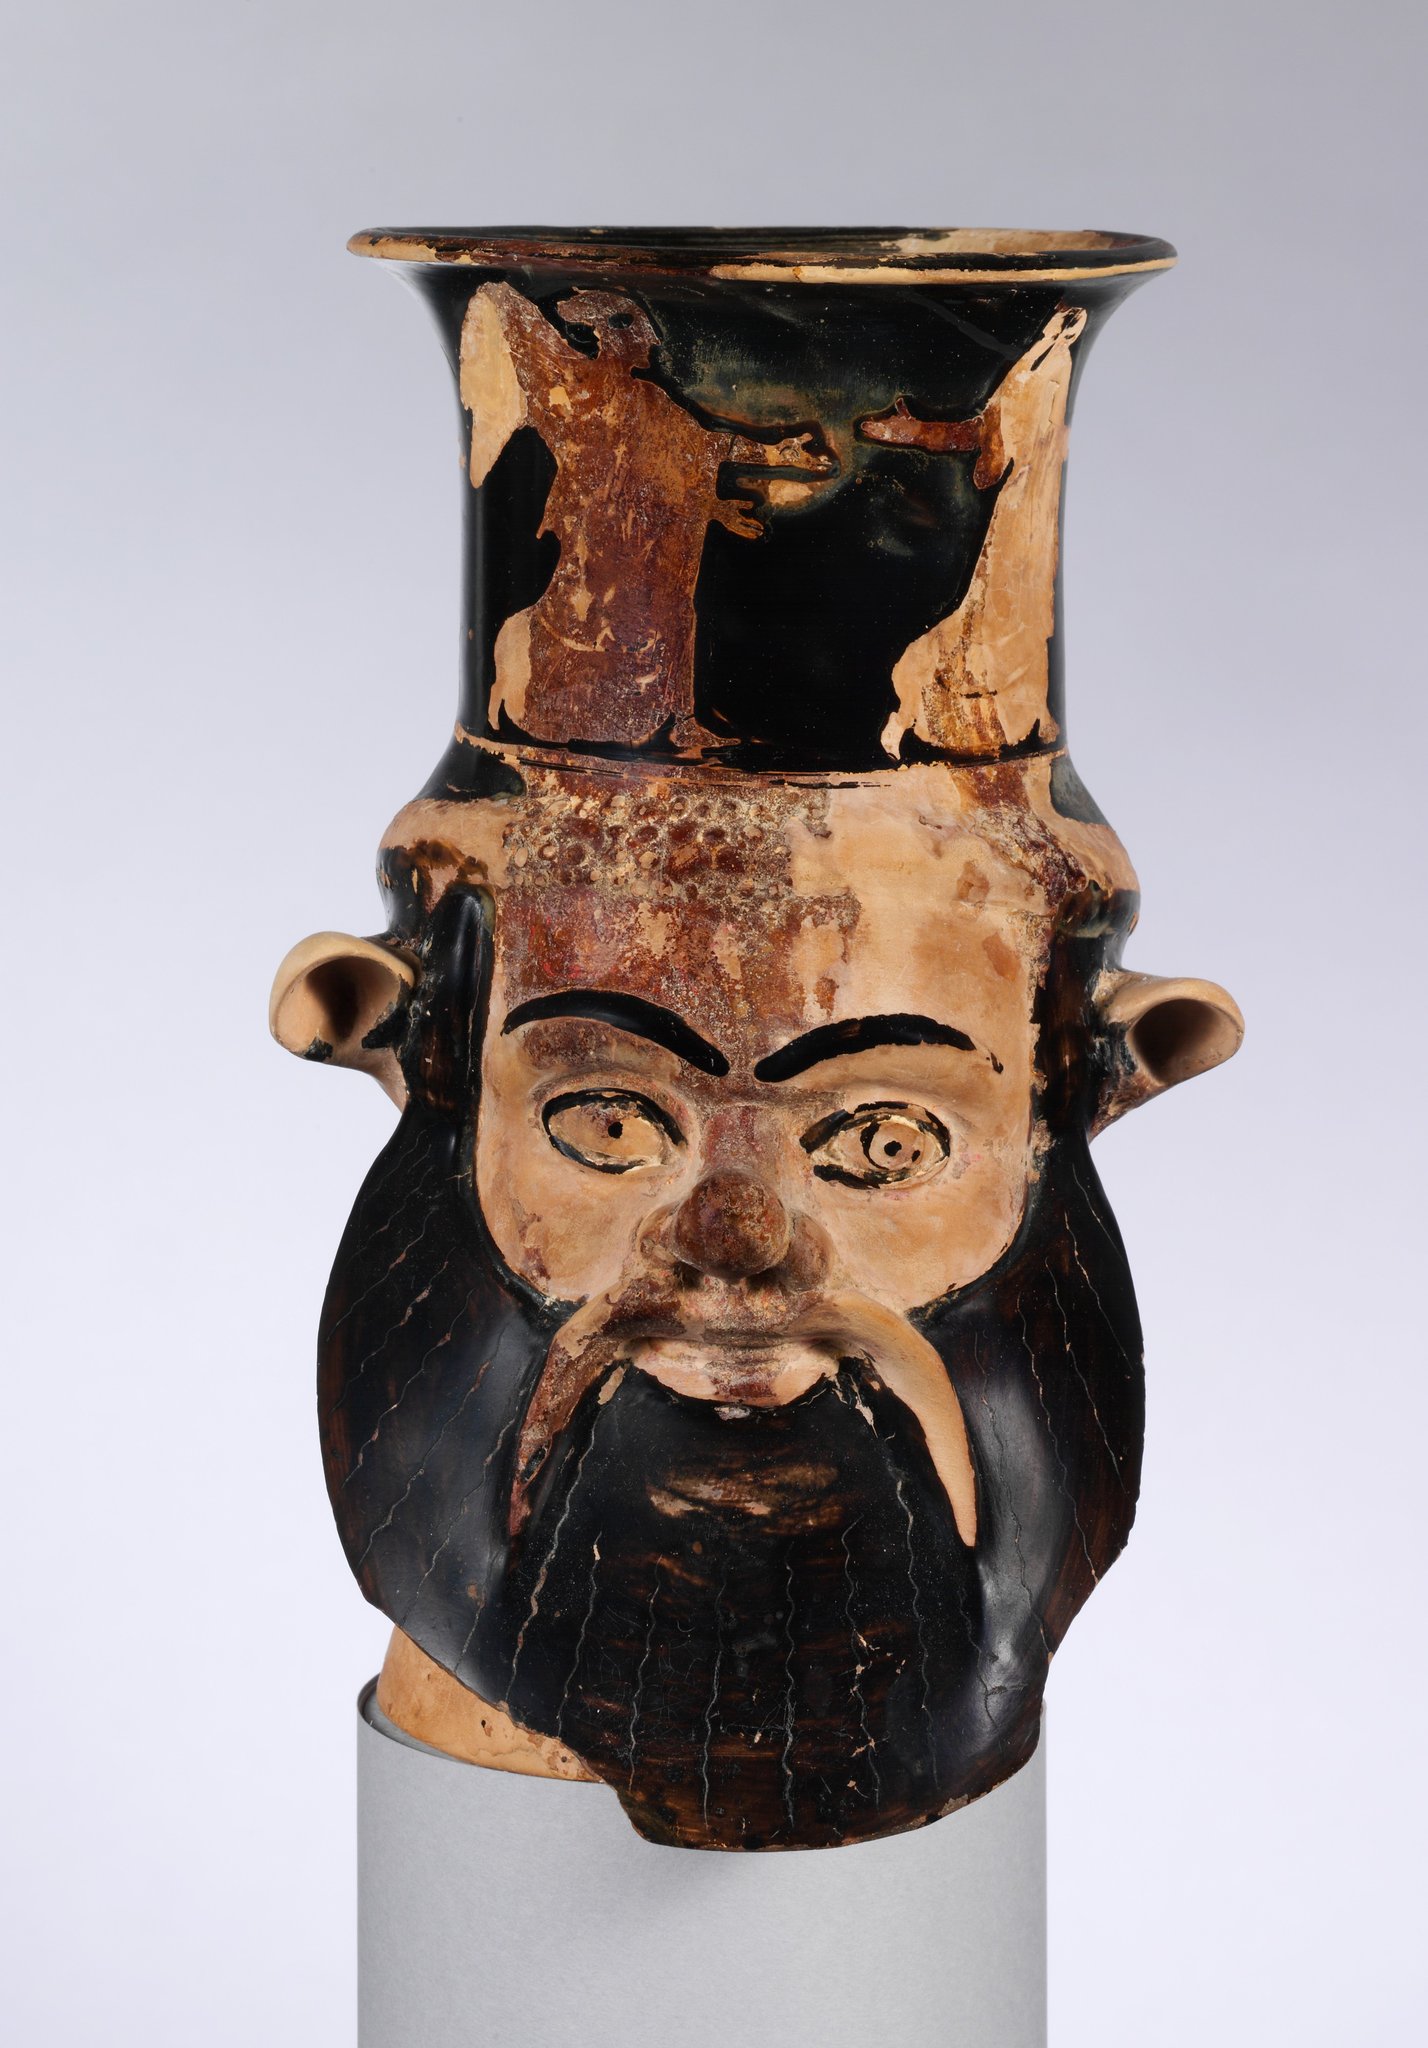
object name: mug in the form of a satyr's head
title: Terracotta mug in the form of a satyr's head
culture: greek, attic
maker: carlsruhe painter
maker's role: artist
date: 460 BCE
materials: terracotta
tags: heads,women,satyrs